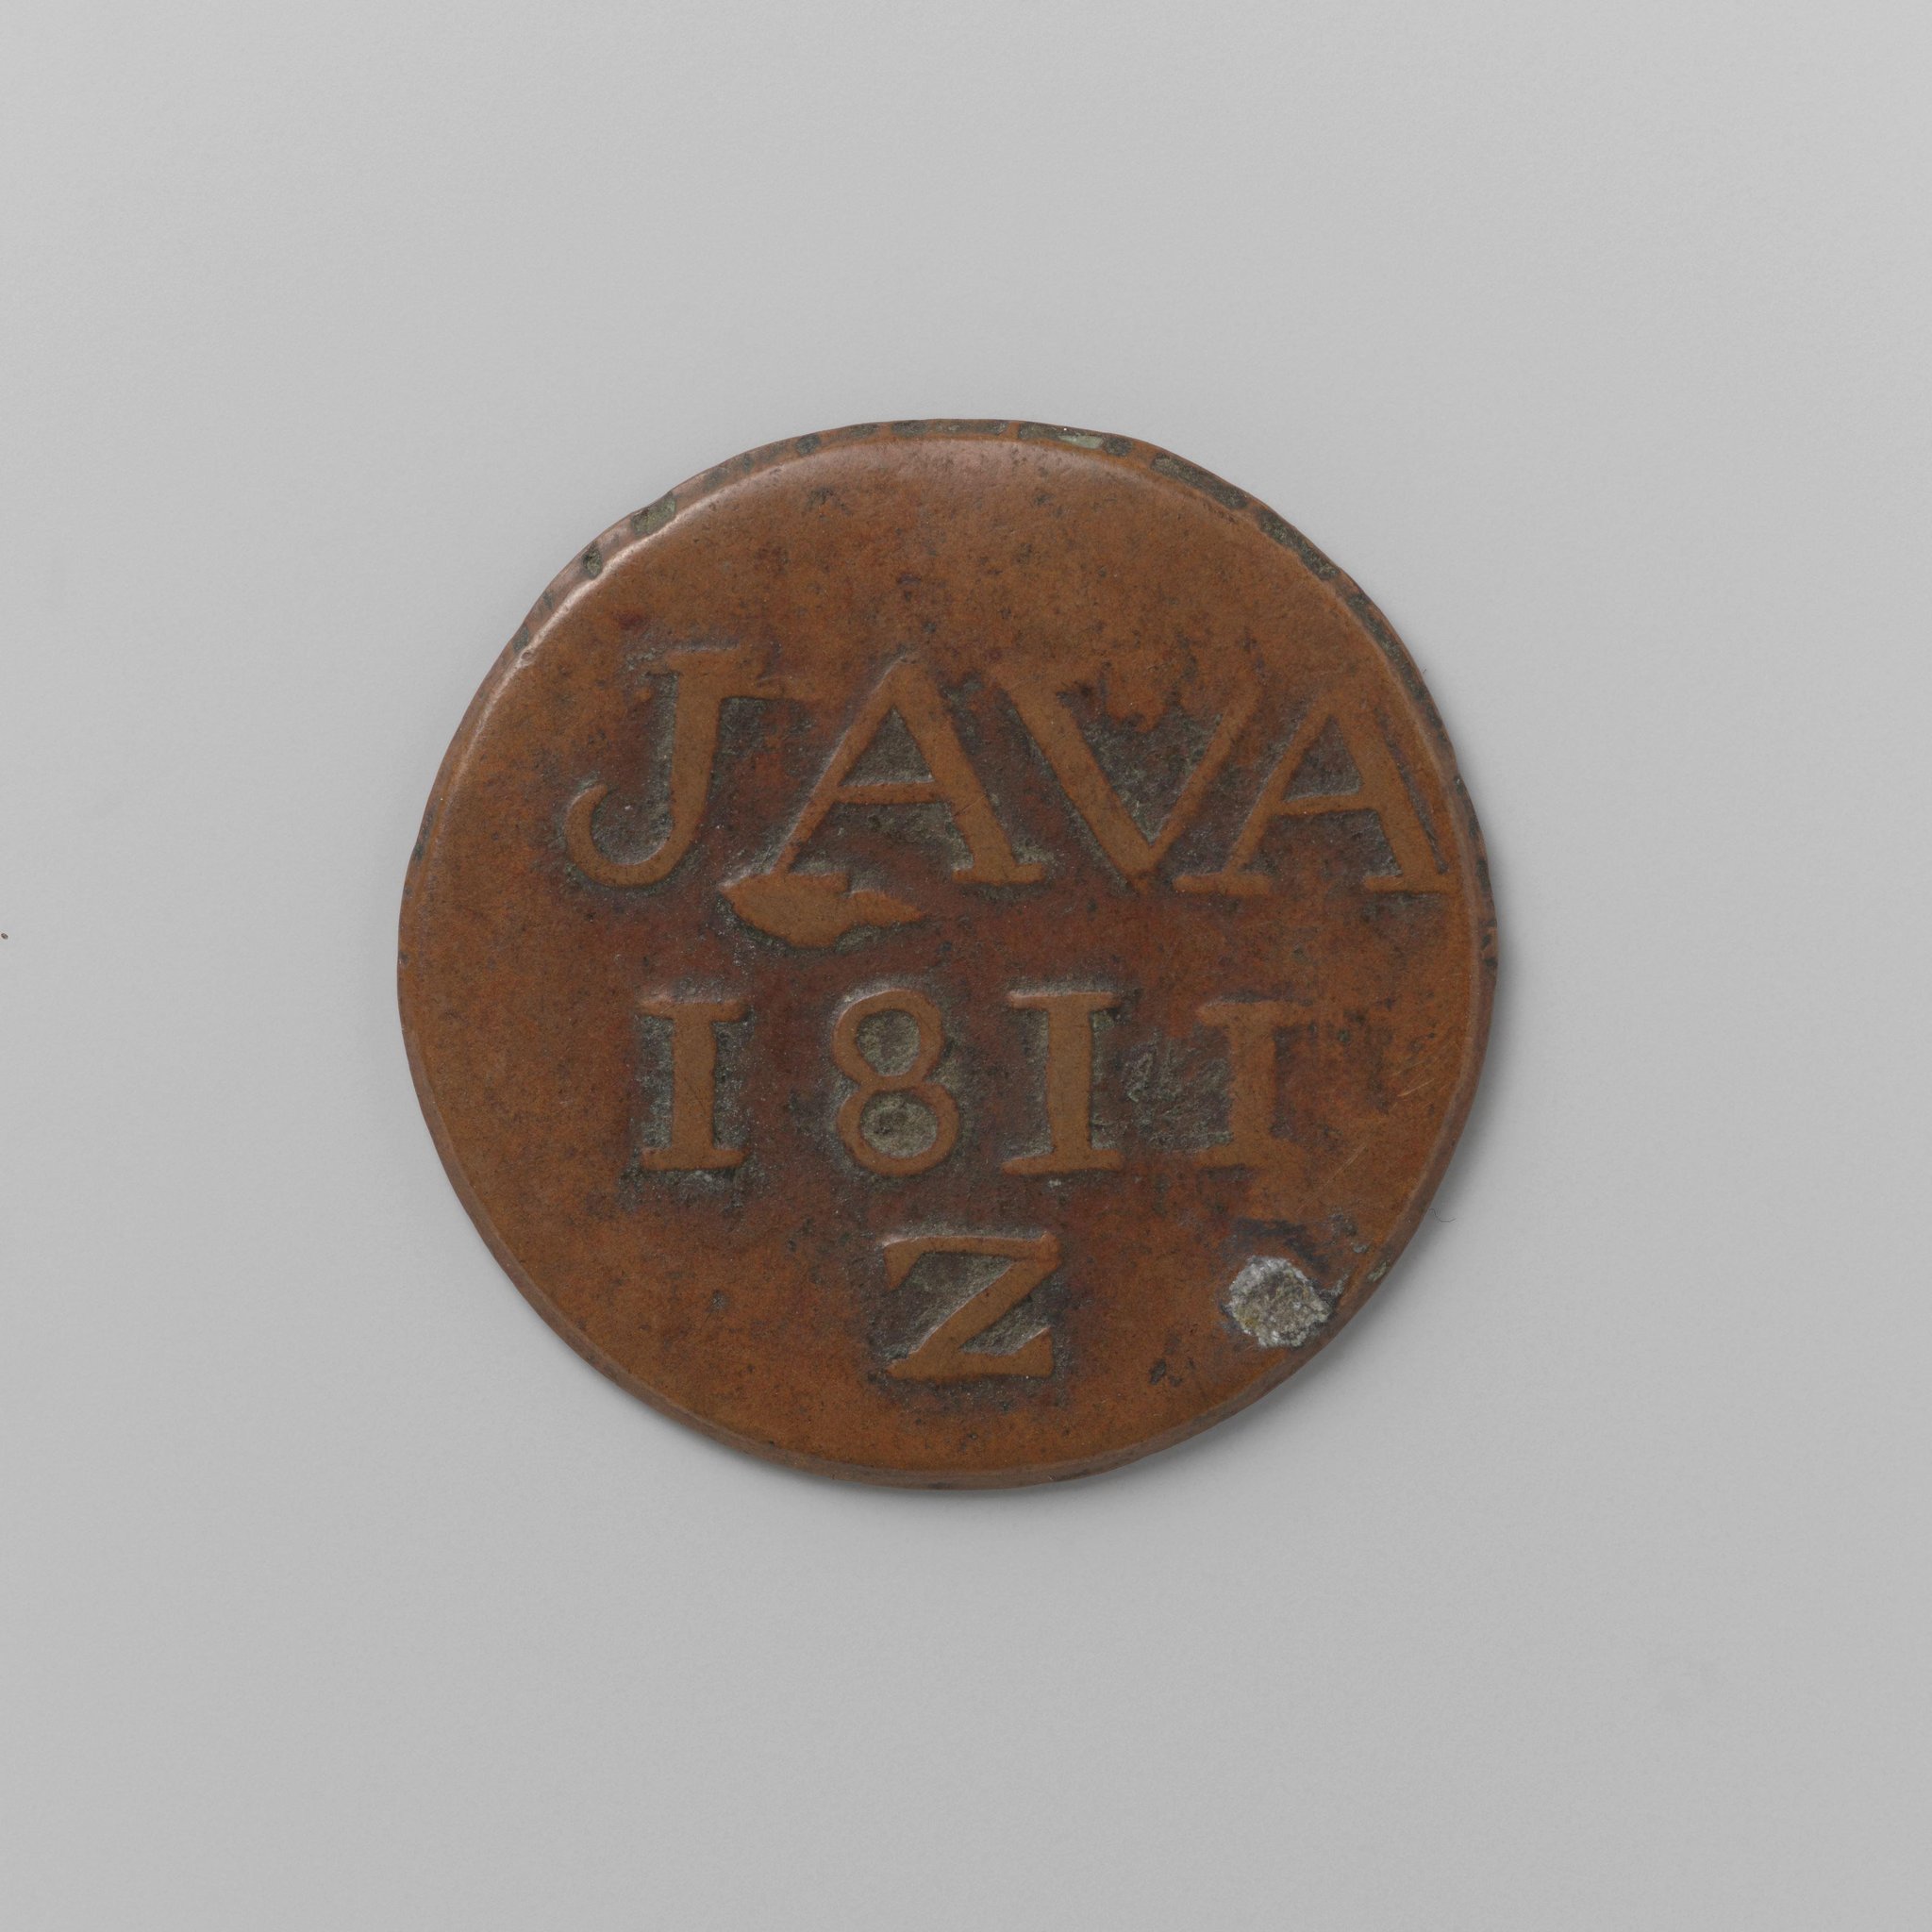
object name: coin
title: Nederlands Indië tijdens Brits bestuur, duit Java,1811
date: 1811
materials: copper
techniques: striking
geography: surabaya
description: Koperen munt. Voorzijde: monogram van de Engelse Oostindische Compagnie. Daarboven letter B [=British]. Keerzijde: eenregelig opschrift, waaronder jaartal. Boven opschrift muntteken en onder jaartal muntmeesterteken Z [=muntmeester Zwekkert].